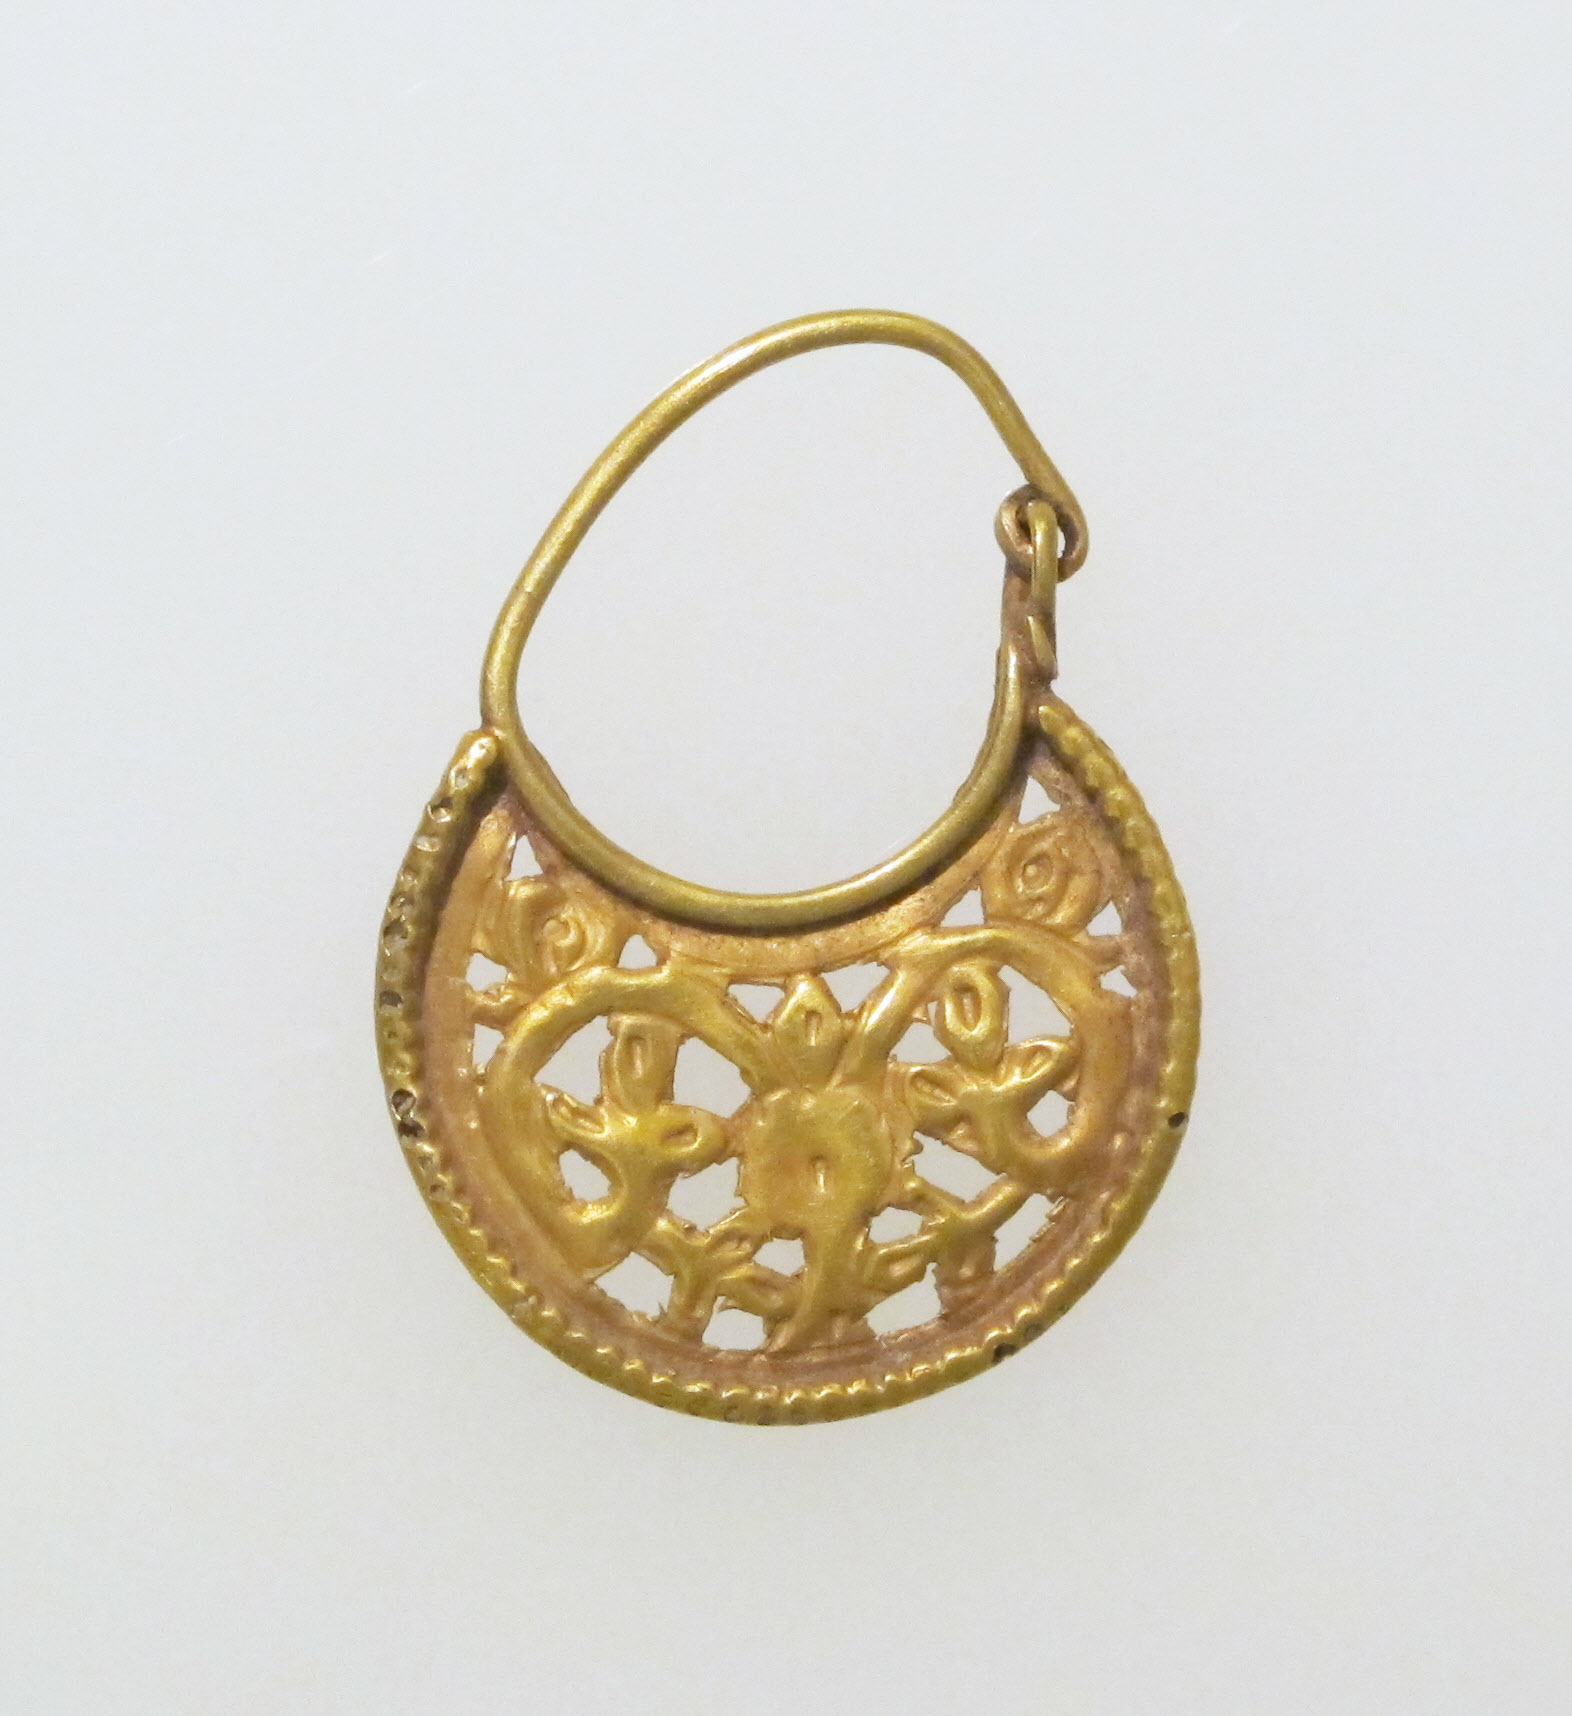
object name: earring, crescent shaped, byzantine style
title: Gold lunate earring with scrolls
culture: byzantine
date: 501-700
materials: gold